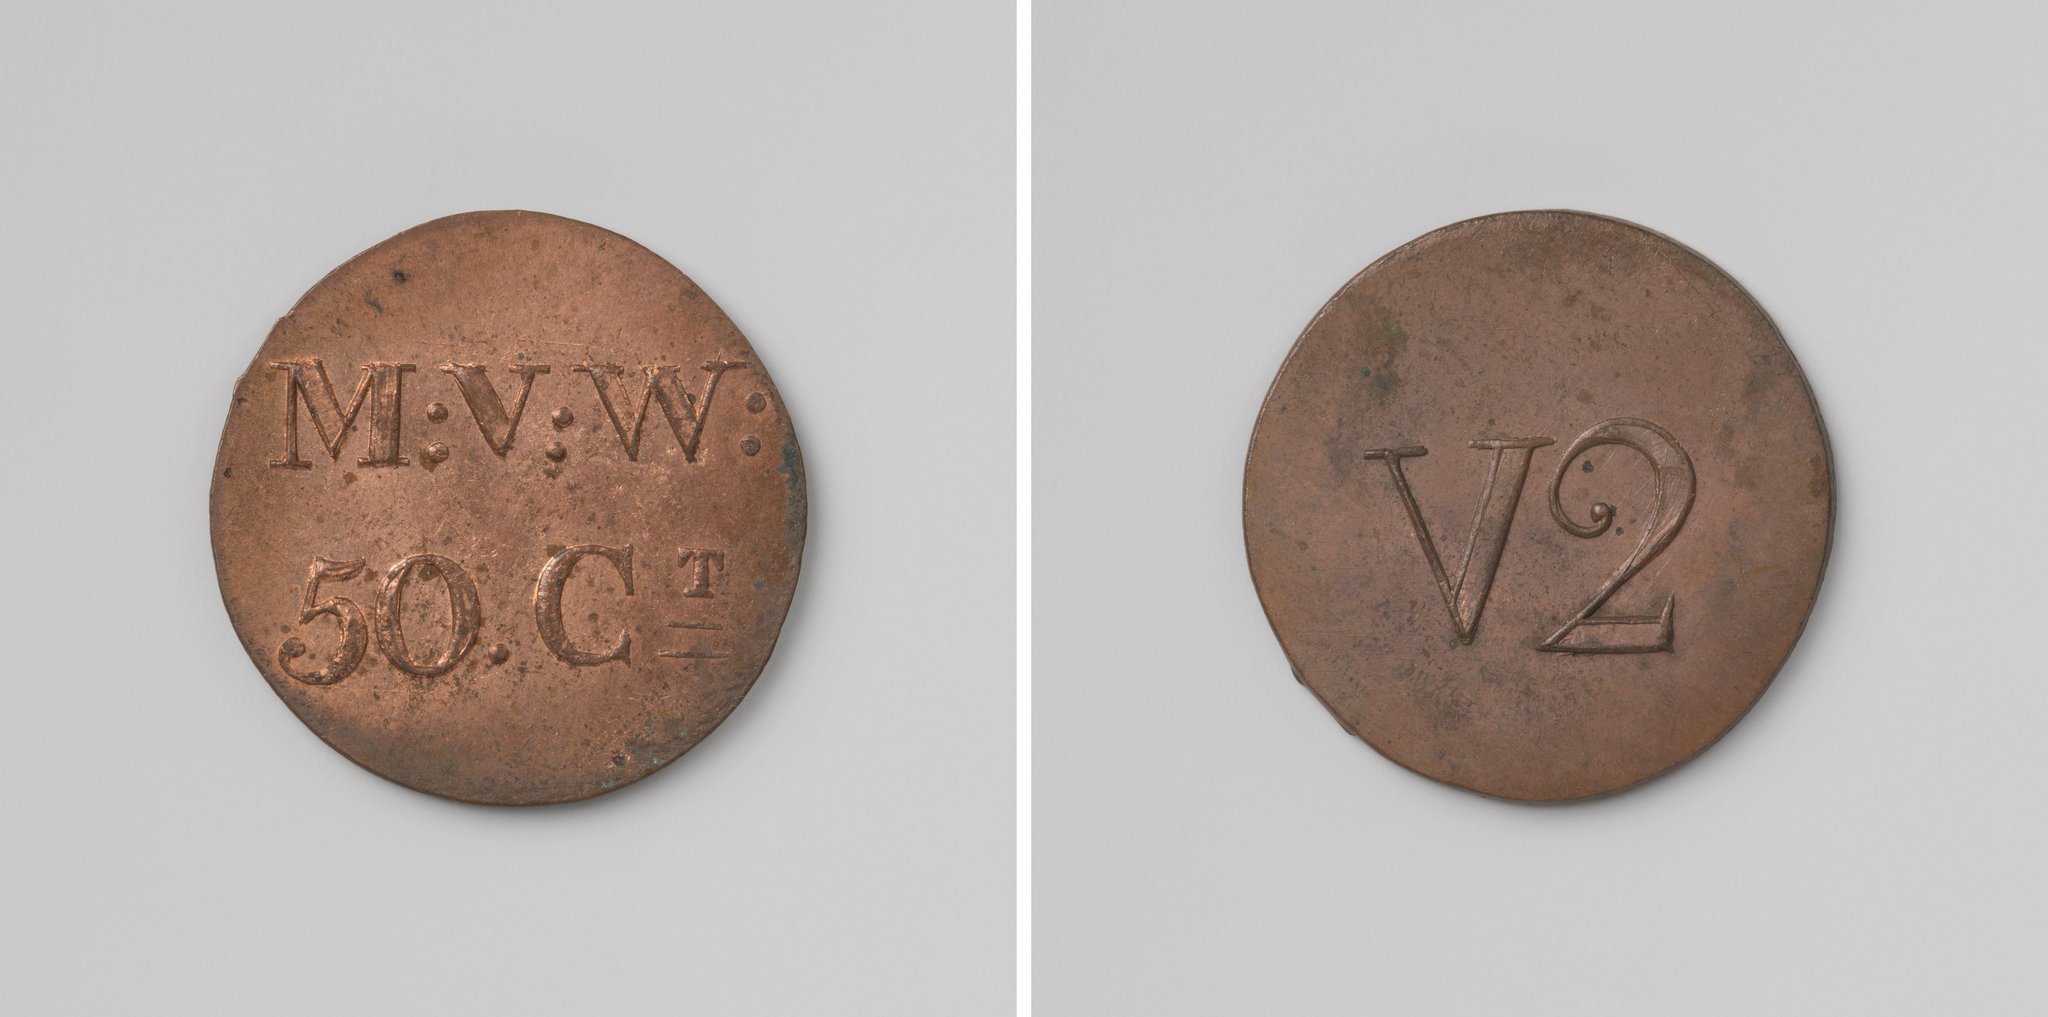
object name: vijftig cent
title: Tweede gesticht van de strafkolonie Veenhuizen, huismunt geslagen op last van de Maatschappij van Weldadigheid ter waarde van 50 cent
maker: Anonymous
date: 1818-1859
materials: copper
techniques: striking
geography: netherlands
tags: maatschappij van weldadigheid, veenhuizen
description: Voorzijde: opschrift boven waardeaanduiding. Keerzijde: opschrift V 2